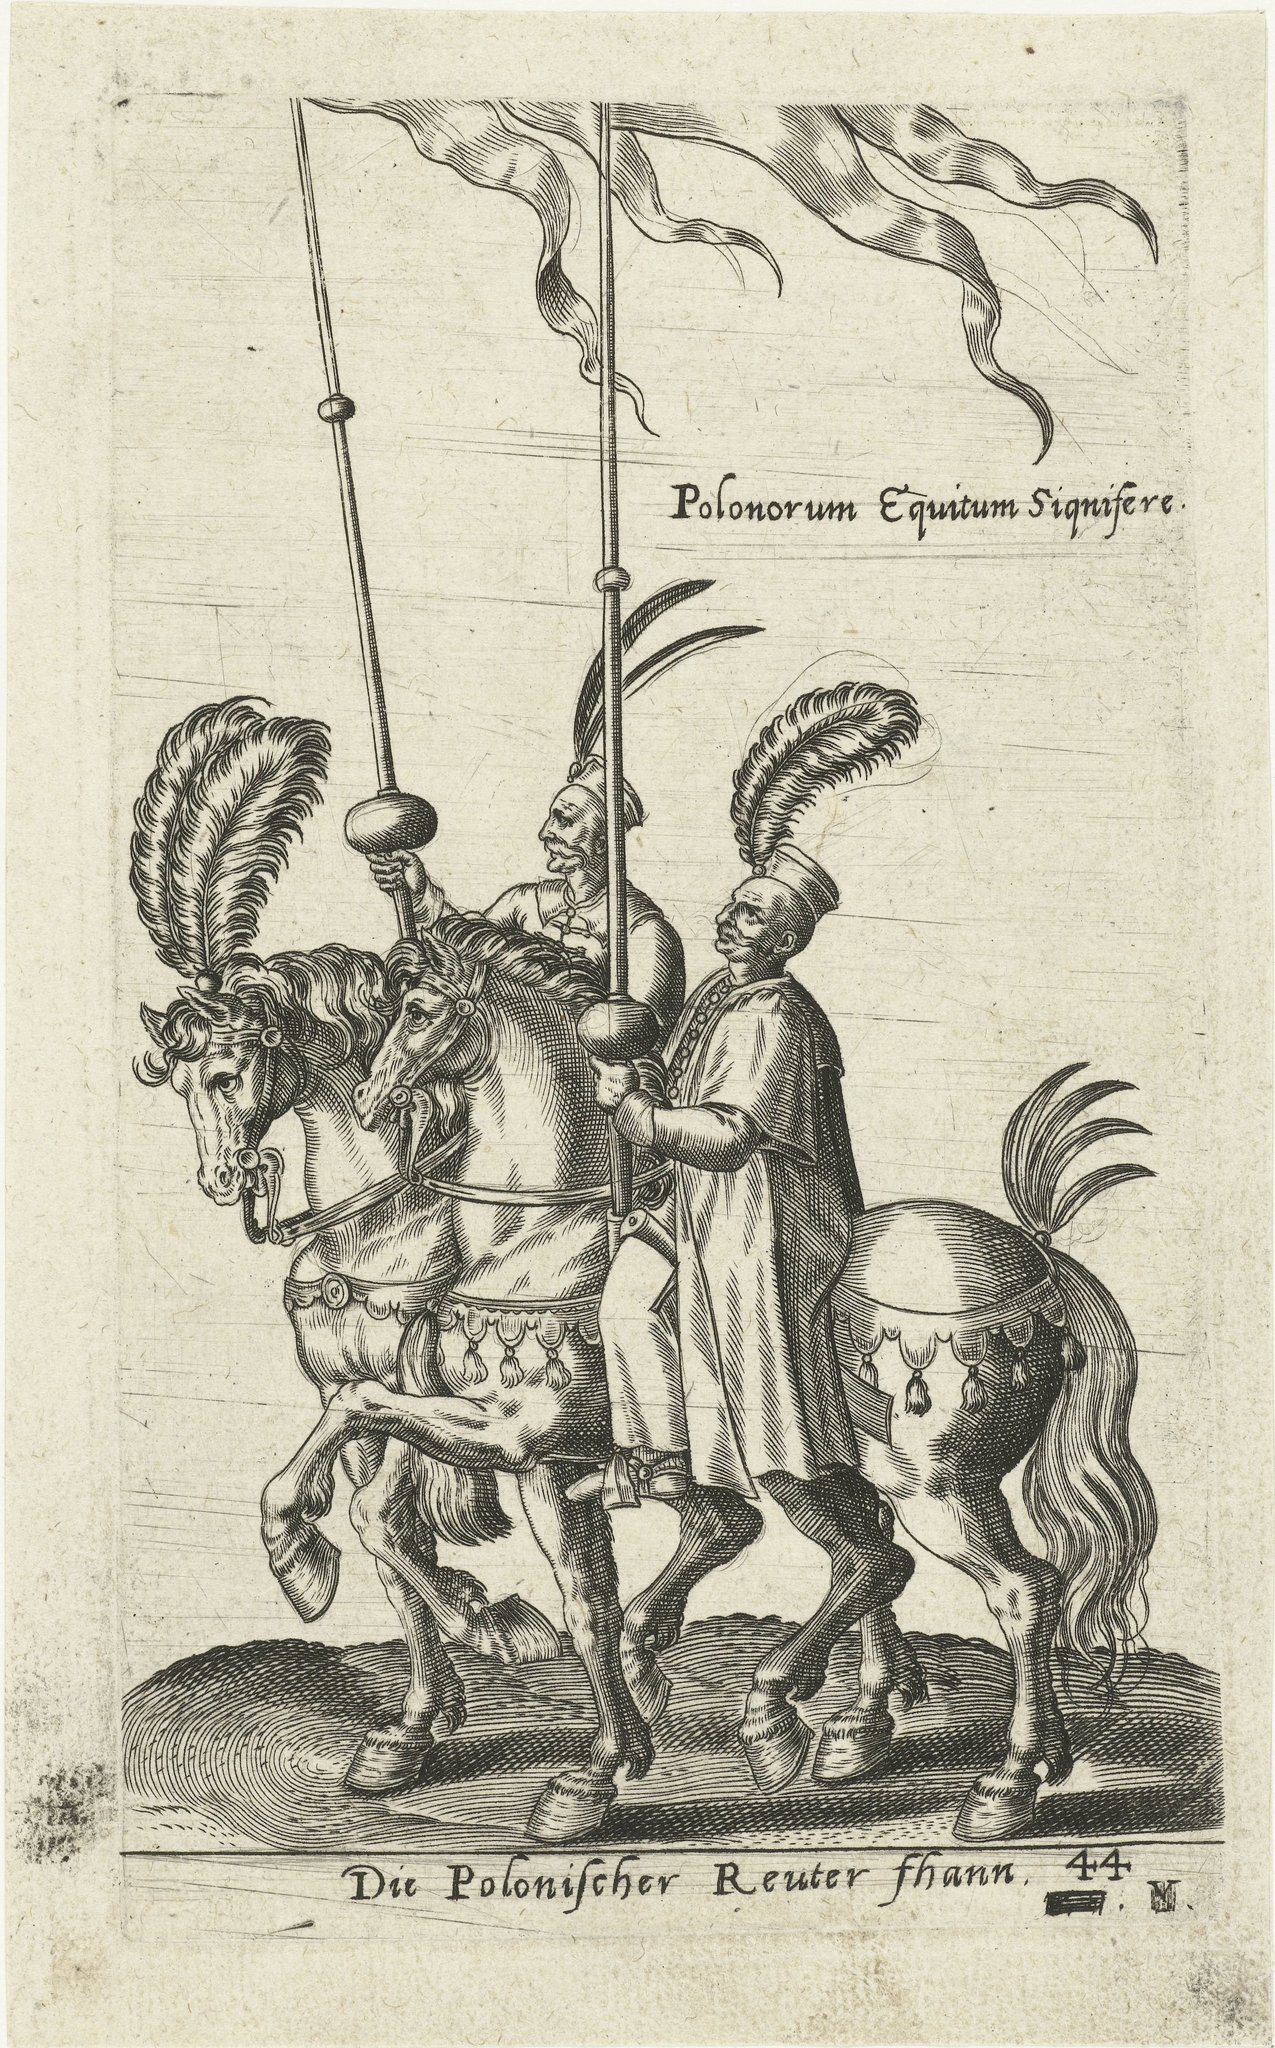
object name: costume print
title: Twee Poolse vaandeldragers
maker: abraham de bruyn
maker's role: print maker, publisher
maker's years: 1540-1587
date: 1577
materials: paper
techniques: engraving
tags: standard-bearer, flag-bearer, warfare; military affairs (+ cavalry, horsemen), folk costume, regional costume, (military) uniforms, europeans (with name)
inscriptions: collector's mark: Lugt 2228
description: Twee paarden en ruiters naar links. De paarden zijn in stap. De ruiters zijn op zijn Pools gekleed. Ze dragen allebei een vaandel. De prent heeft een Duits onderschrift en Latijns opschrift. Prent oorspronkelijk uit 'Equitum descripcio...', 1577.